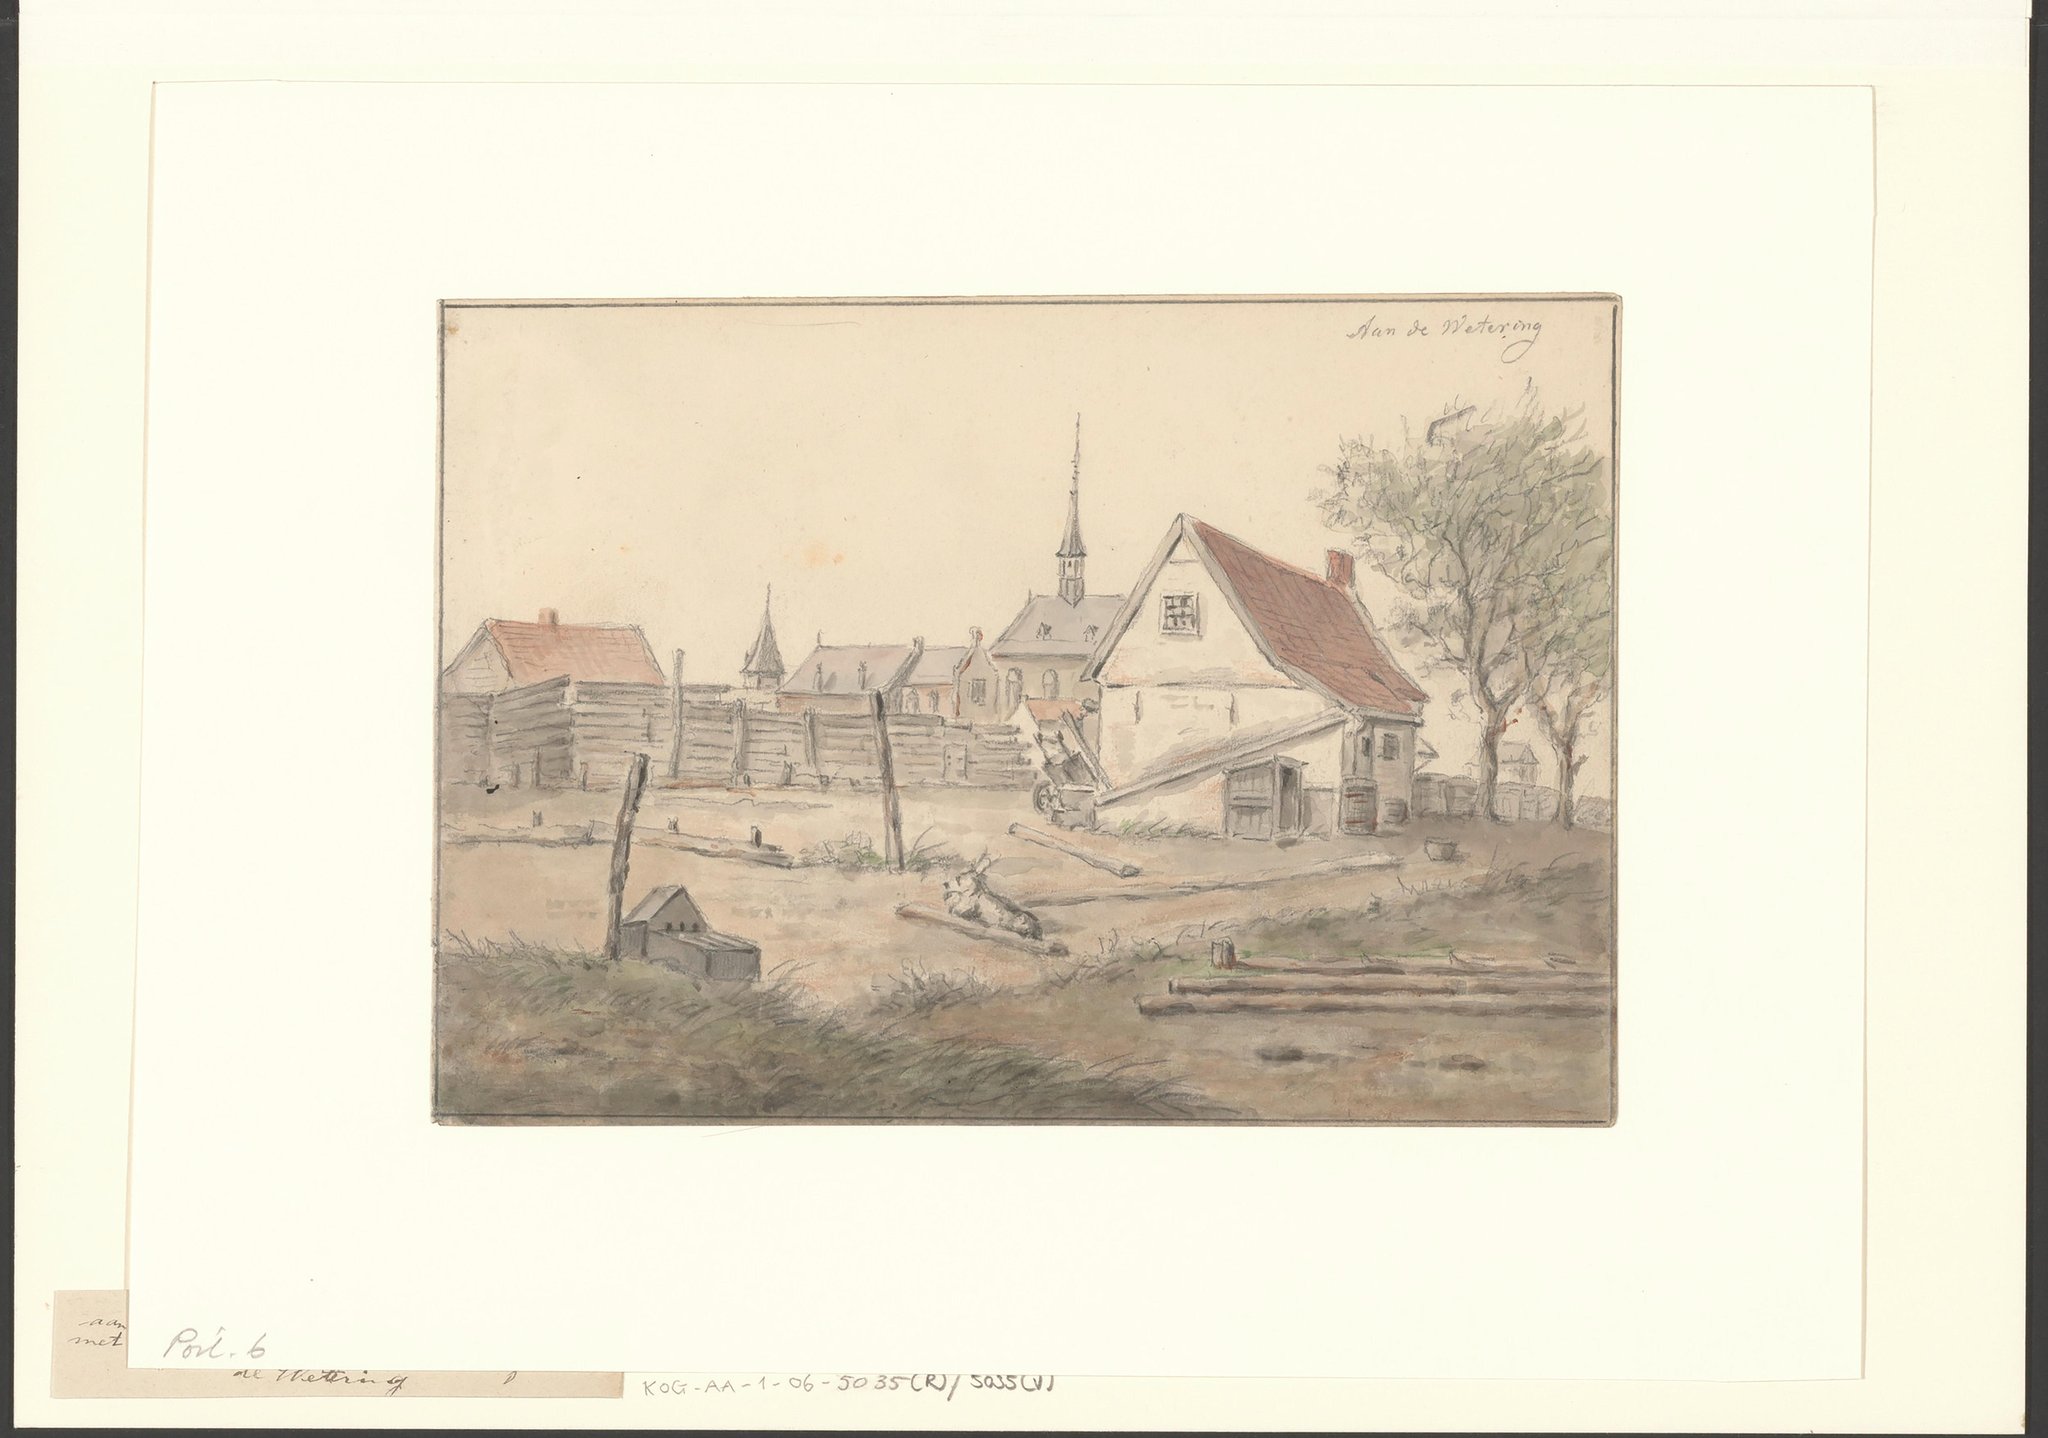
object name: drawing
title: Gezicht op kerk De Liefde, gezien vanaf de Kostverloren Wetering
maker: albert martin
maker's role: draughtsman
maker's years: 1827-1900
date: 1837-1900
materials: paper, pencil, watercolor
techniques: brush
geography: amsterdam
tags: city-view in general; 'veduta', church (exterior)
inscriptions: inscription: ‘aan de achterzeide (...) vanaf / de Wetering’, inscription: ‘Port. 6’, inscription: ‘Aan de Wetering’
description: Onderwerpsrubriek binnen de Atlas Amsterdam: Buijskade, Catskade (Jacob), Clercqstraat (de), Commelinstraat, Costakade (da), Cuypstraat (Albert), Czaar Peterstraat.